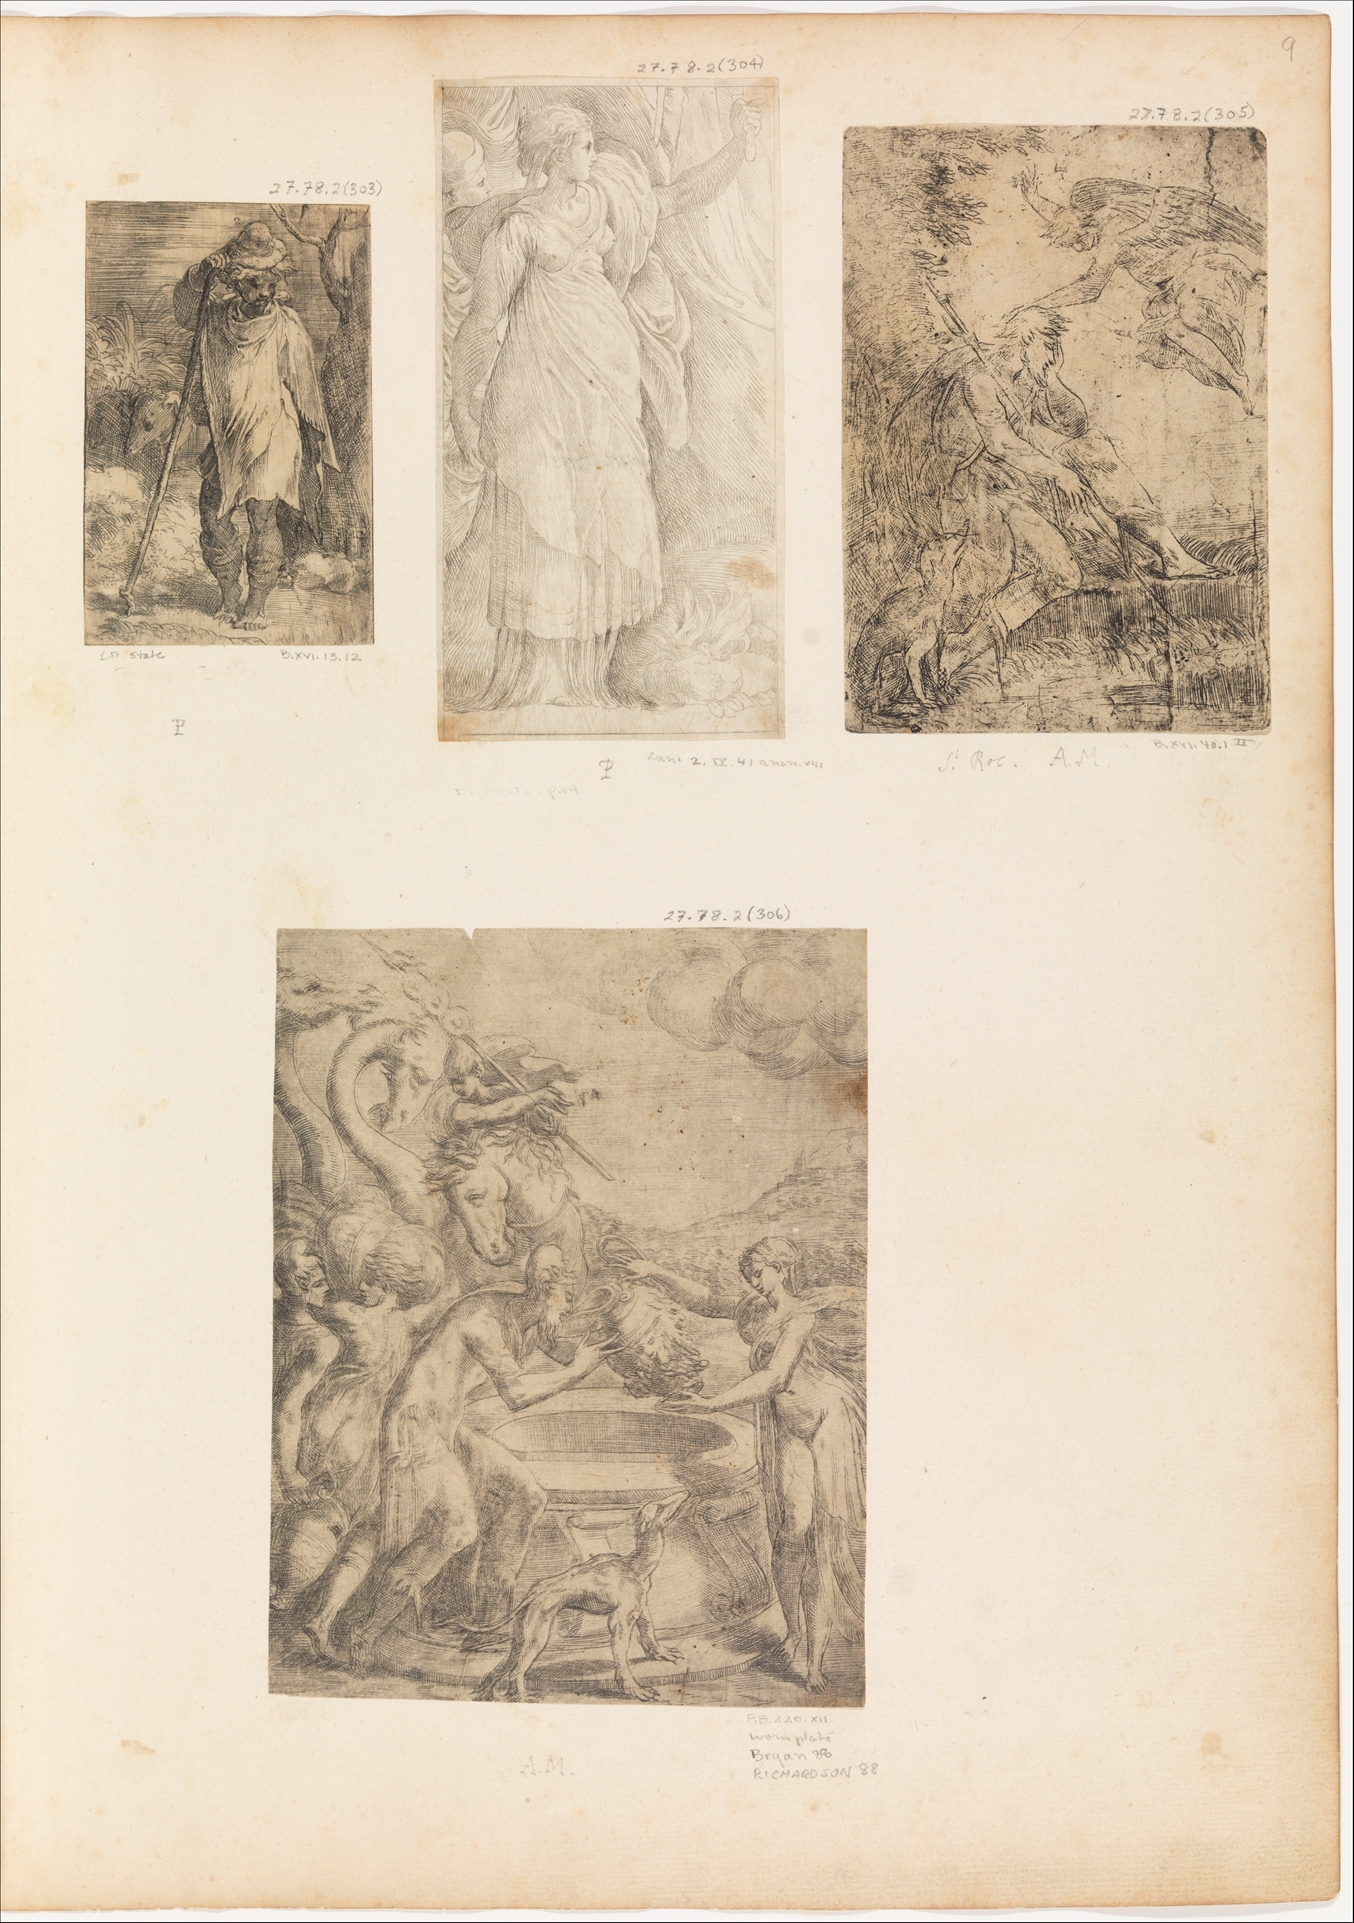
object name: print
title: St. Roch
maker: andrea schiavone (andrea meldola)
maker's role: artist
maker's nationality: italian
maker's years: 1510-1563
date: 1538-1540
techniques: etching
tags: women,mythical creatures,saints